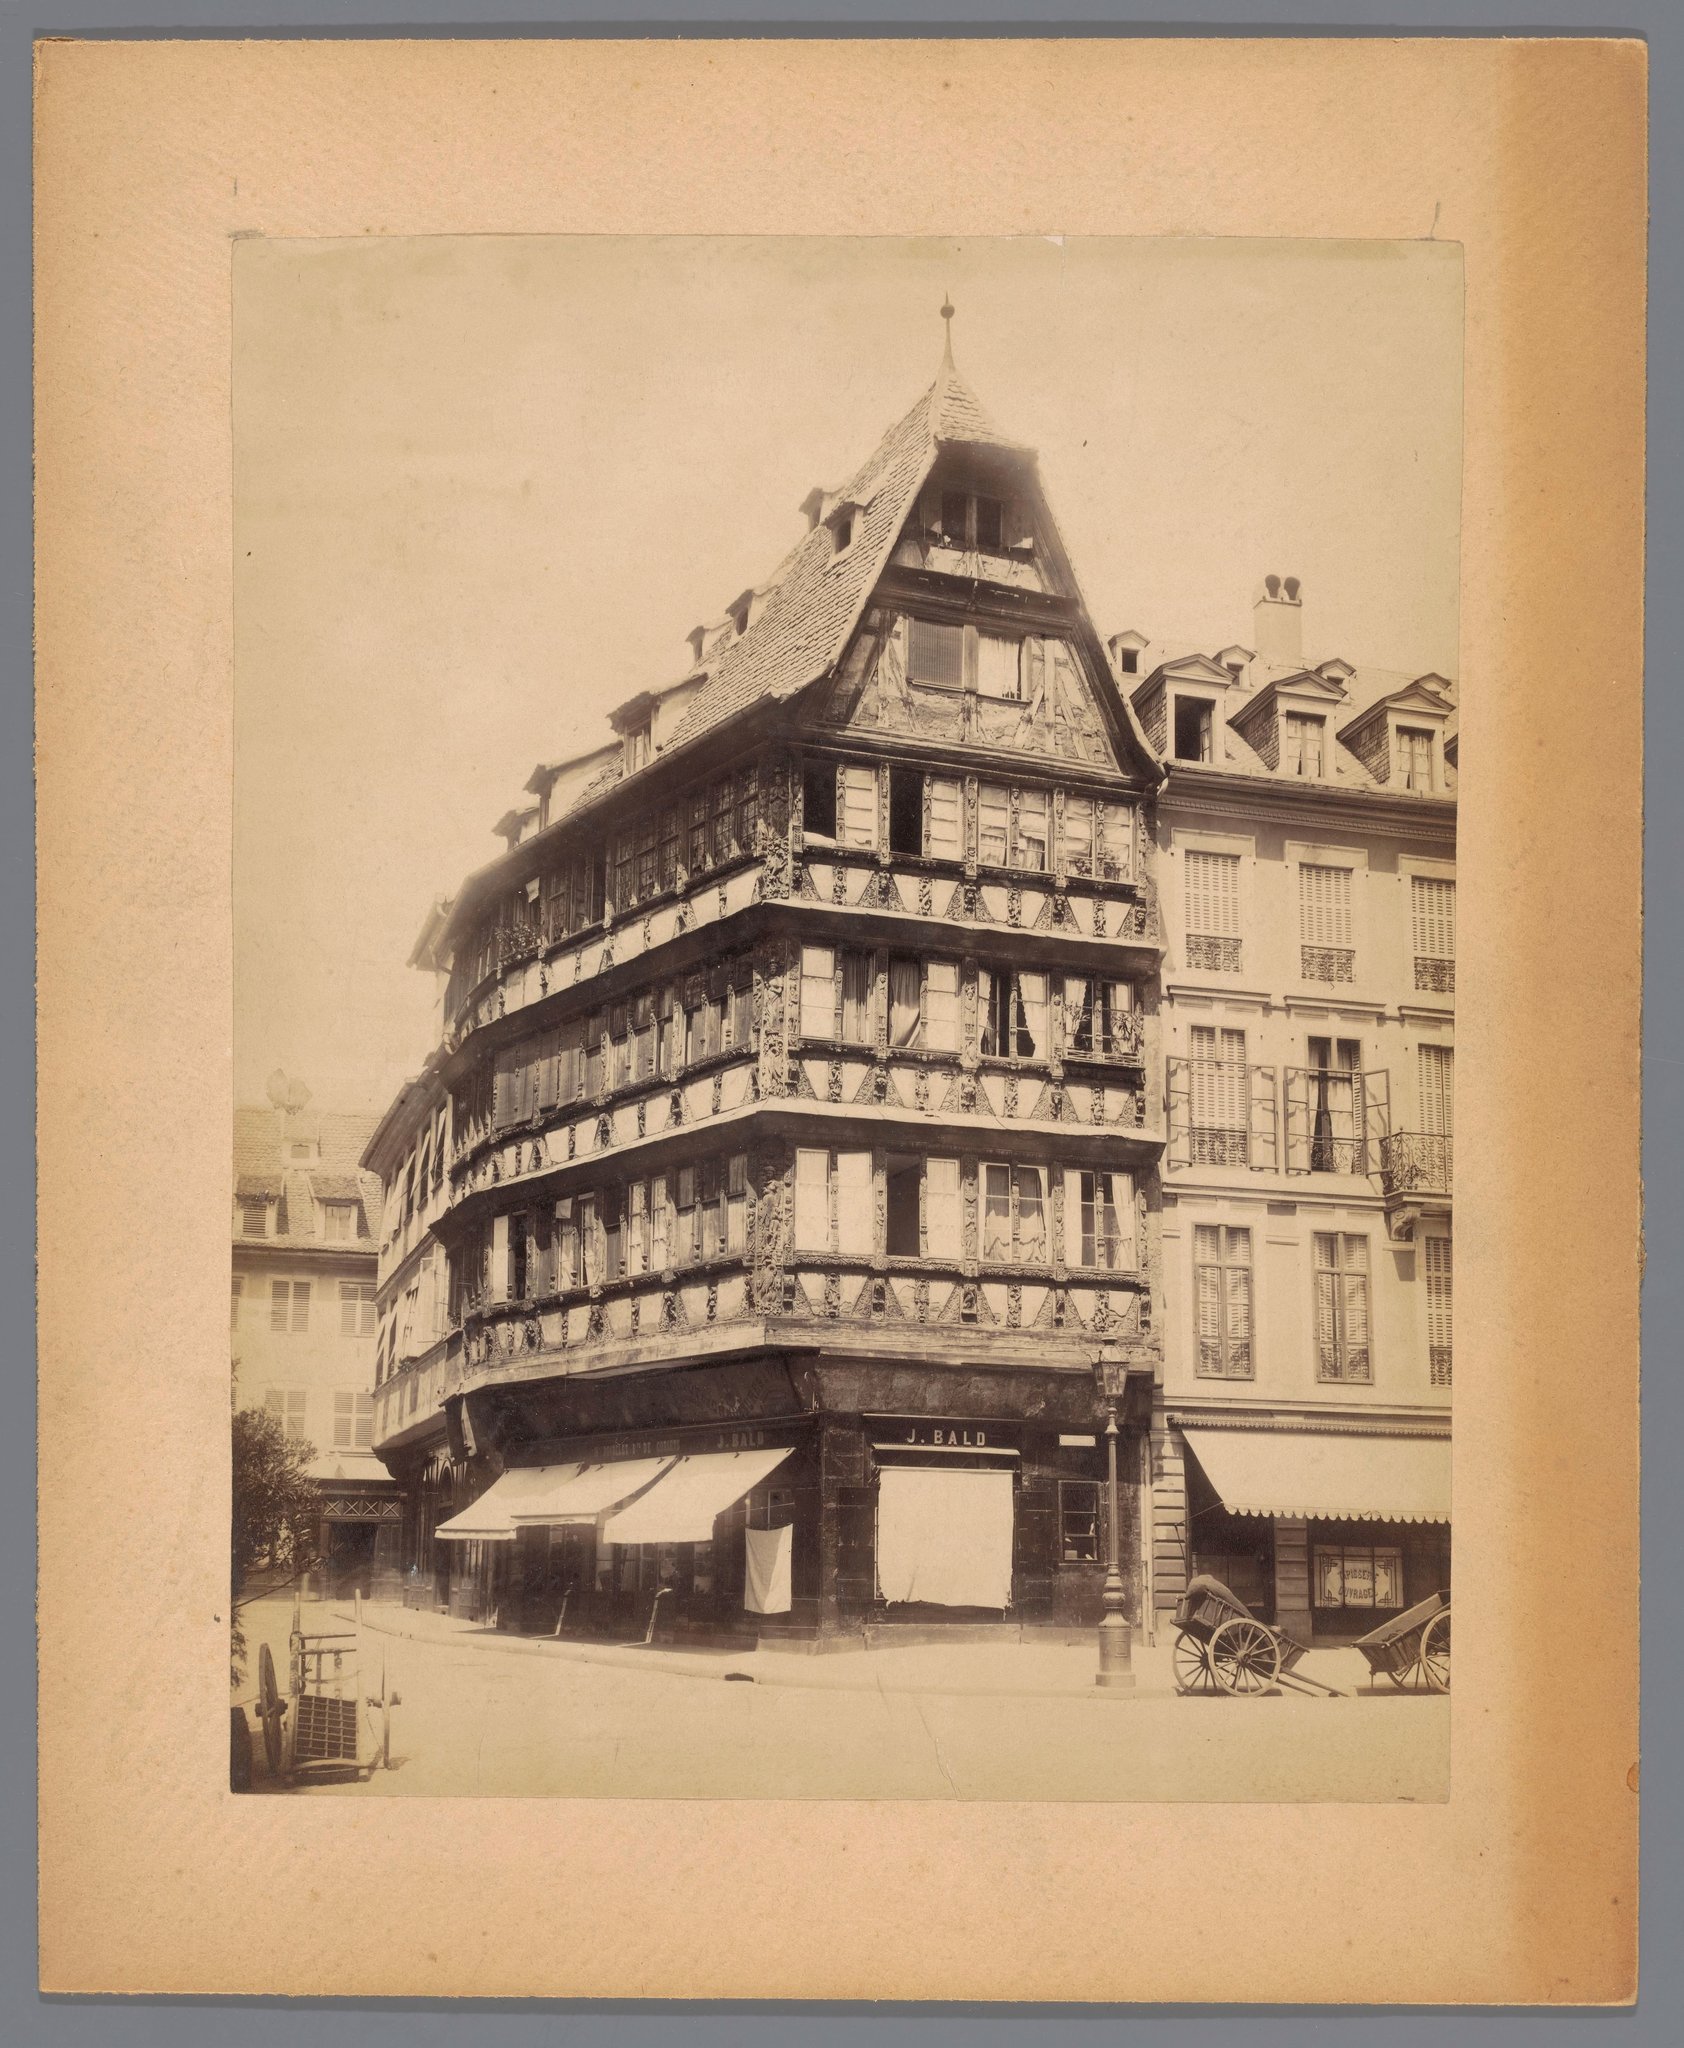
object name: photograph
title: Vakwerkhuis in Frankrijk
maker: Anonymous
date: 1880-1910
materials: cardboard, paper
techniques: albumen print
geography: france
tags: urban housing, alsace